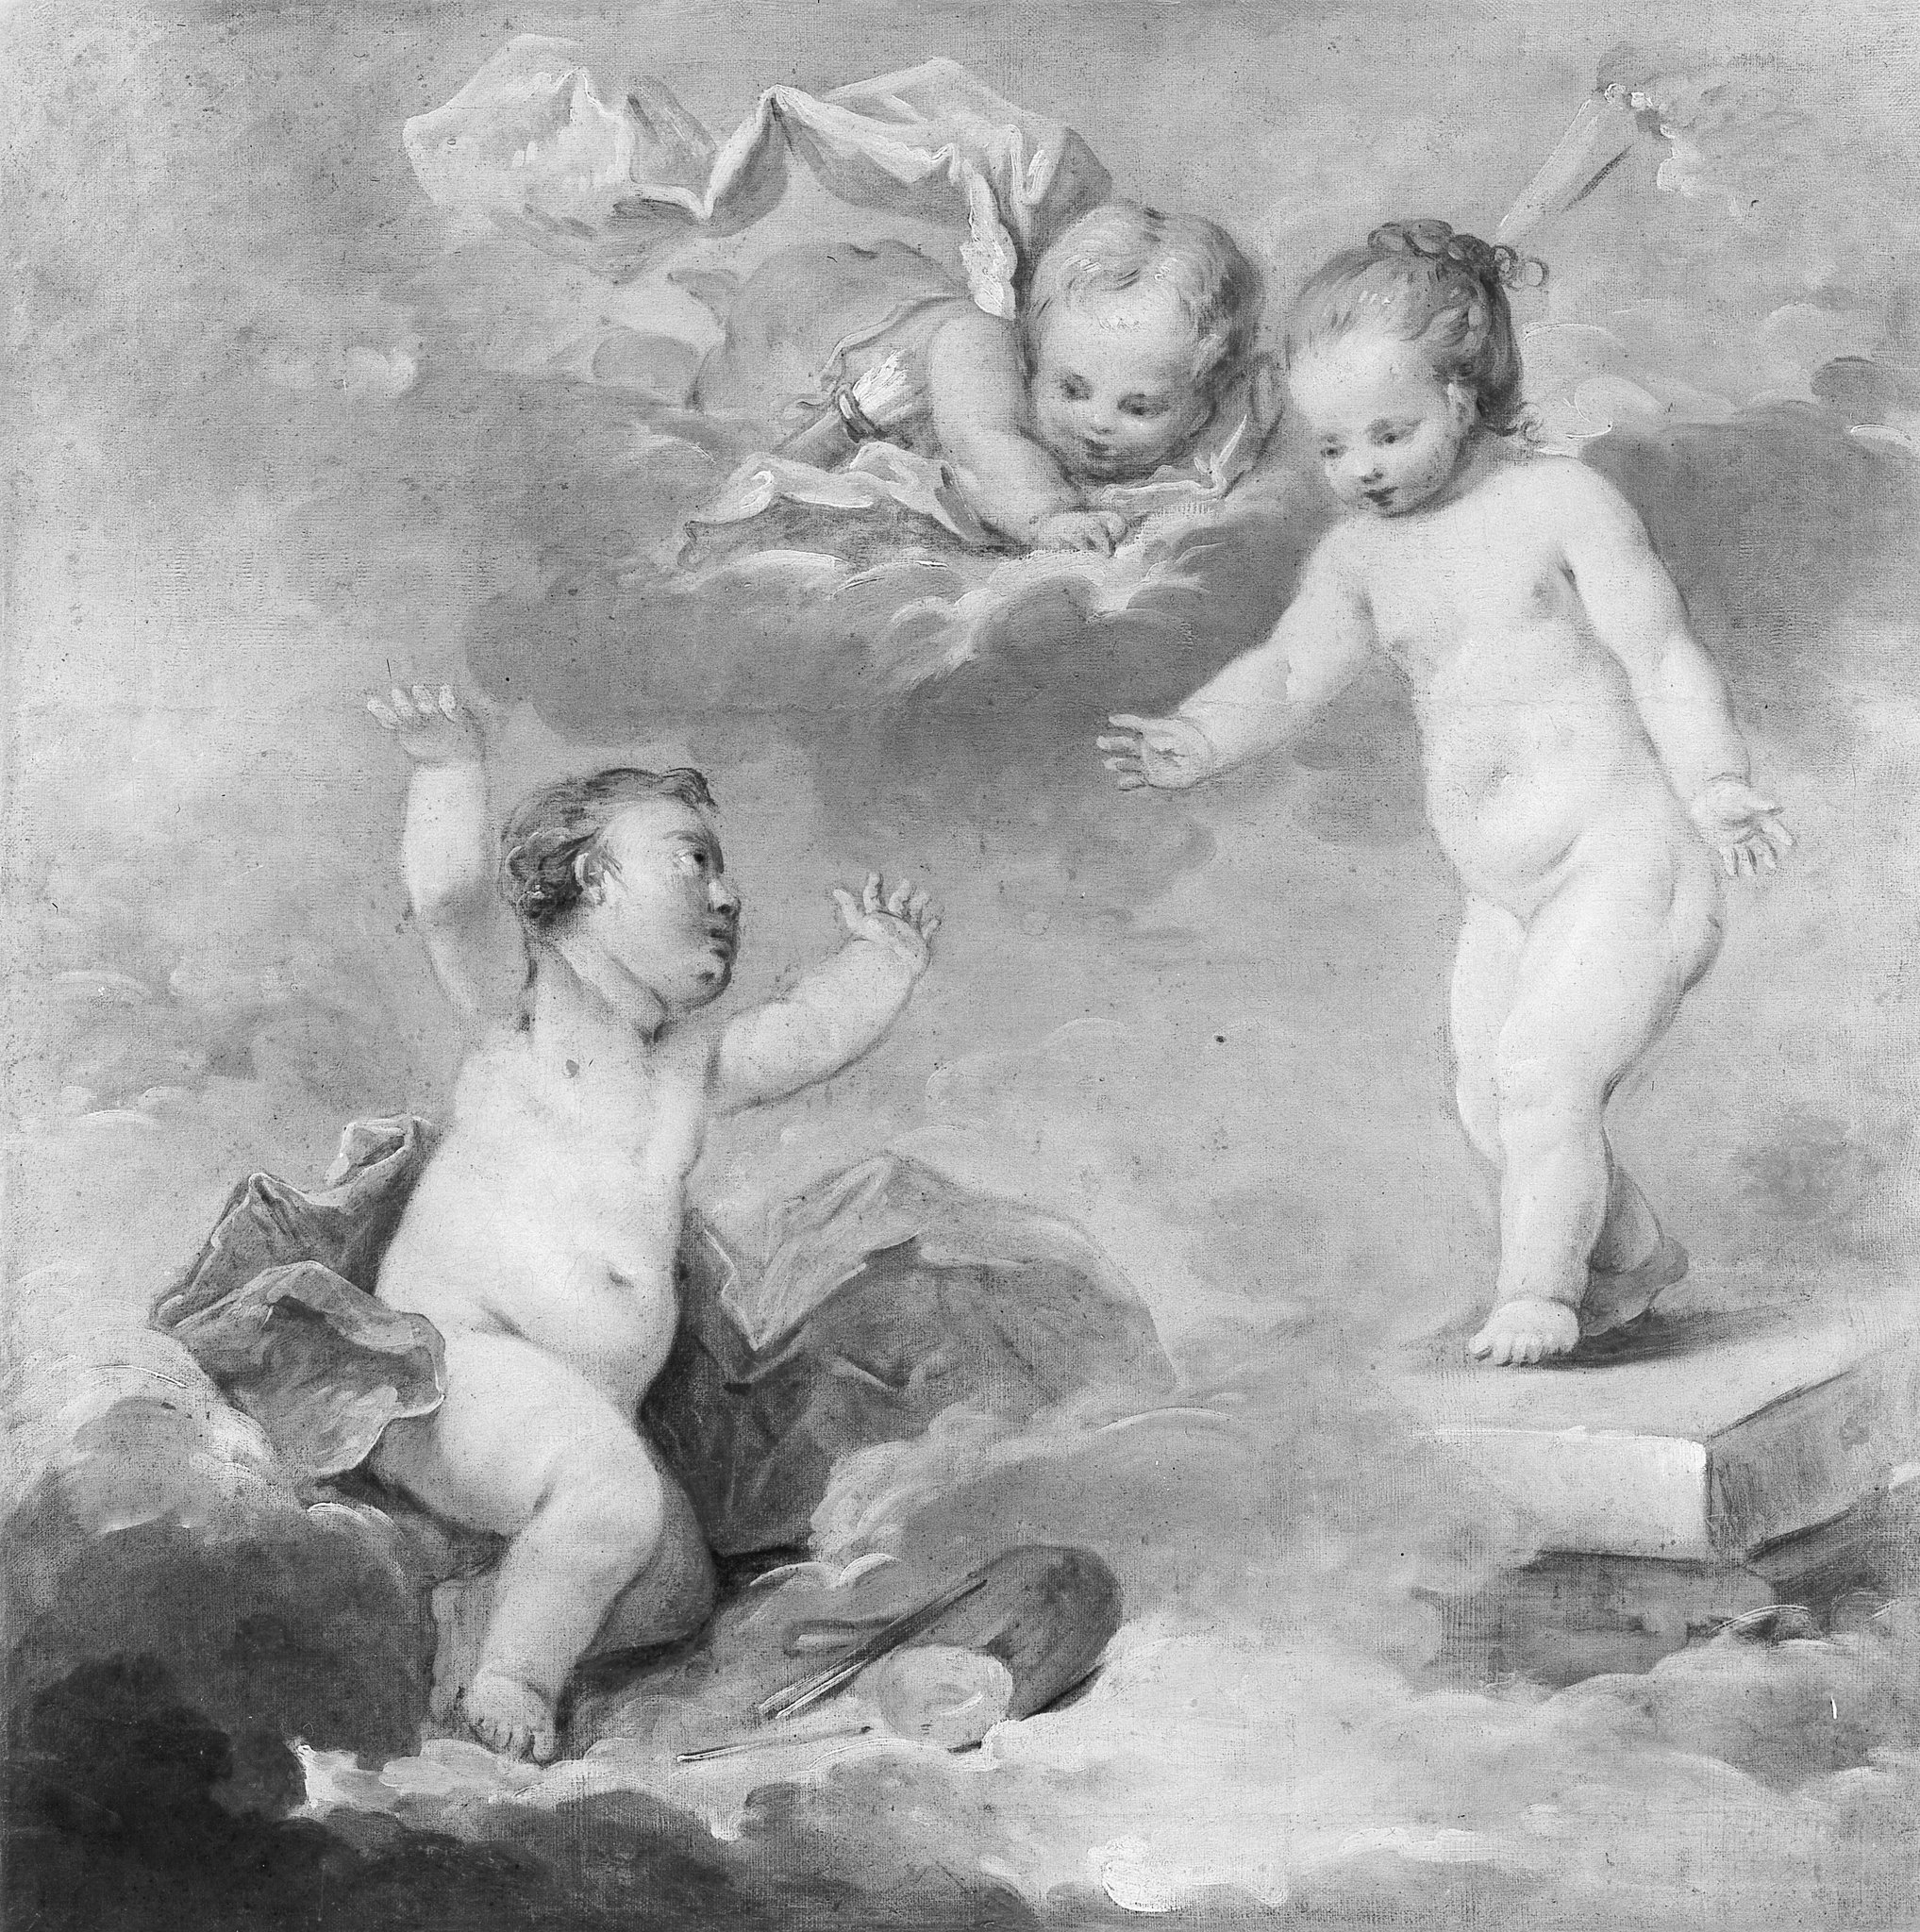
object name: painting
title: Pygmalion and Galatea as Infants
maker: french painter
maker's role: artist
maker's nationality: french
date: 1701-1800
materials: canvas, oil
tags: infants,galatea,pygmalion